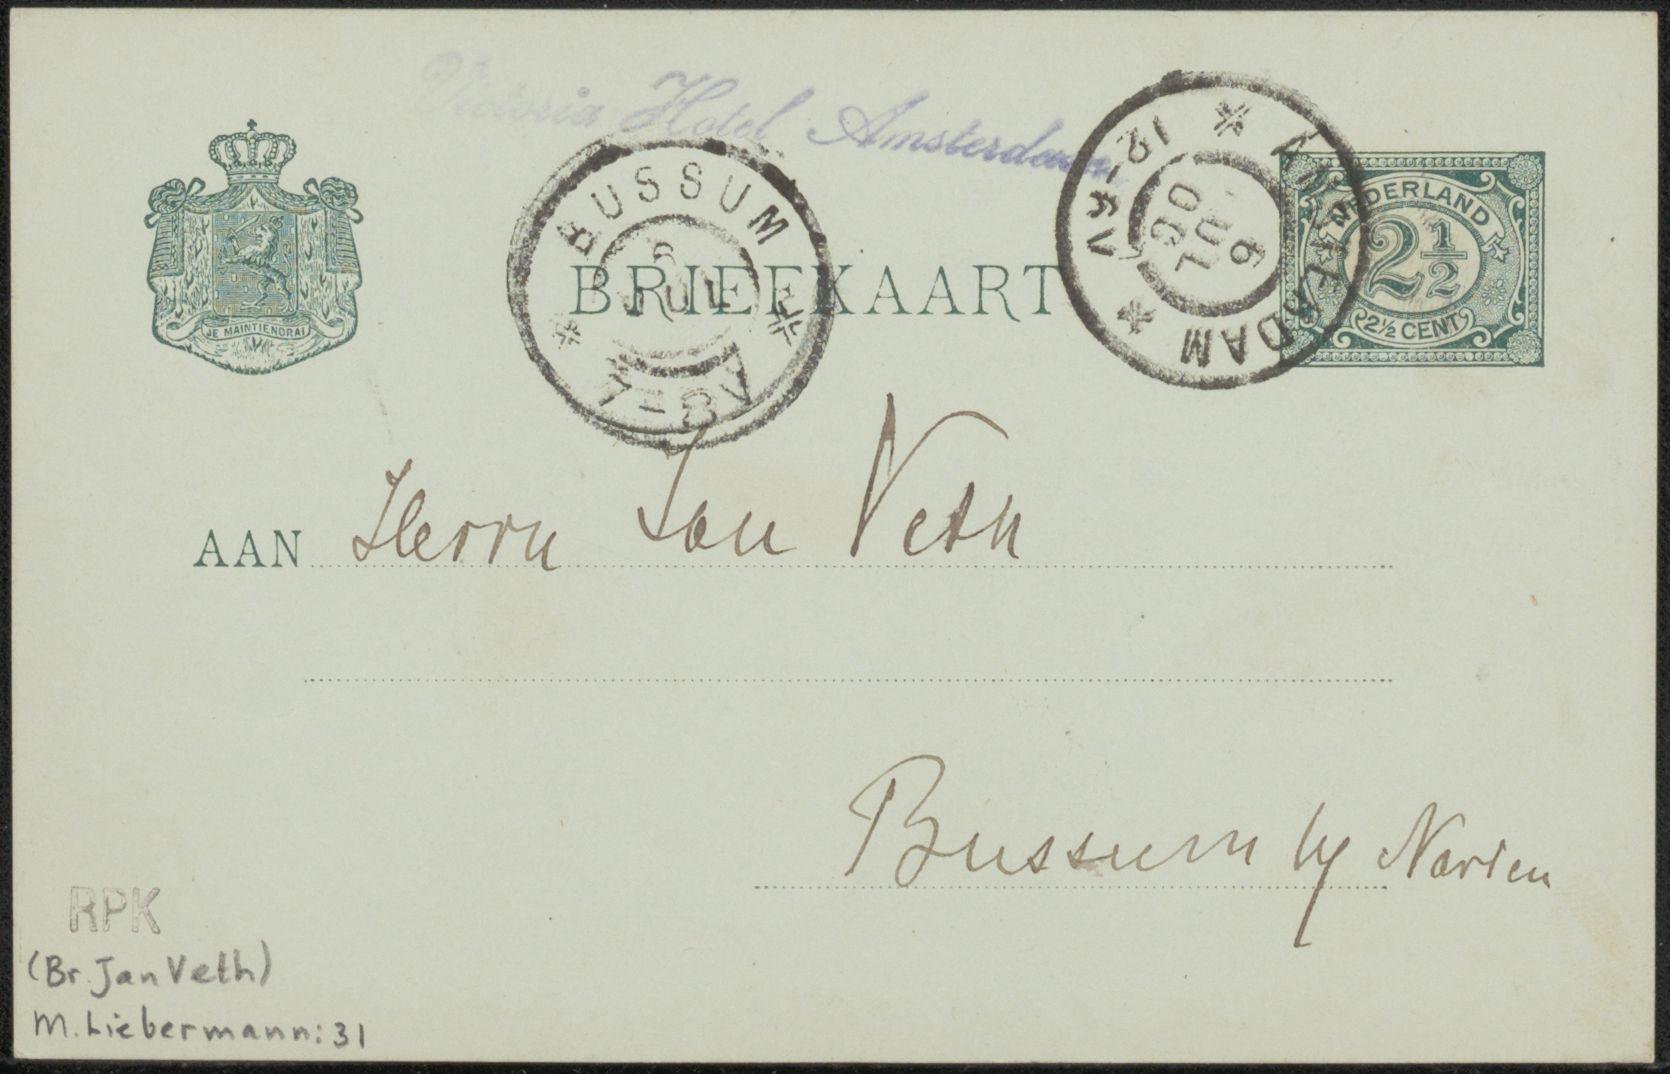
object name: postcard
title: Briefkaart aan Jan Veth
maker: max liebermann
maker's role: draughtsman, print maker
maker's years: 1847-1935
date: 1900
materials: cardboard, ink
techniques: pen, writing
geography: buiksloot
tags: dordrecht, amsterdam, painter, designer, jan veth, publisher, j.h. schorer, leiden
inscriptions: collector's mark: ‘RPK’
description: Opgenomen in: Ernst Braun, Max Liebermann: Briefe 1896-1901, Baden-Baden: Deutscher Wissenschafts-Verlag, 2012, Band 2, p. 375.